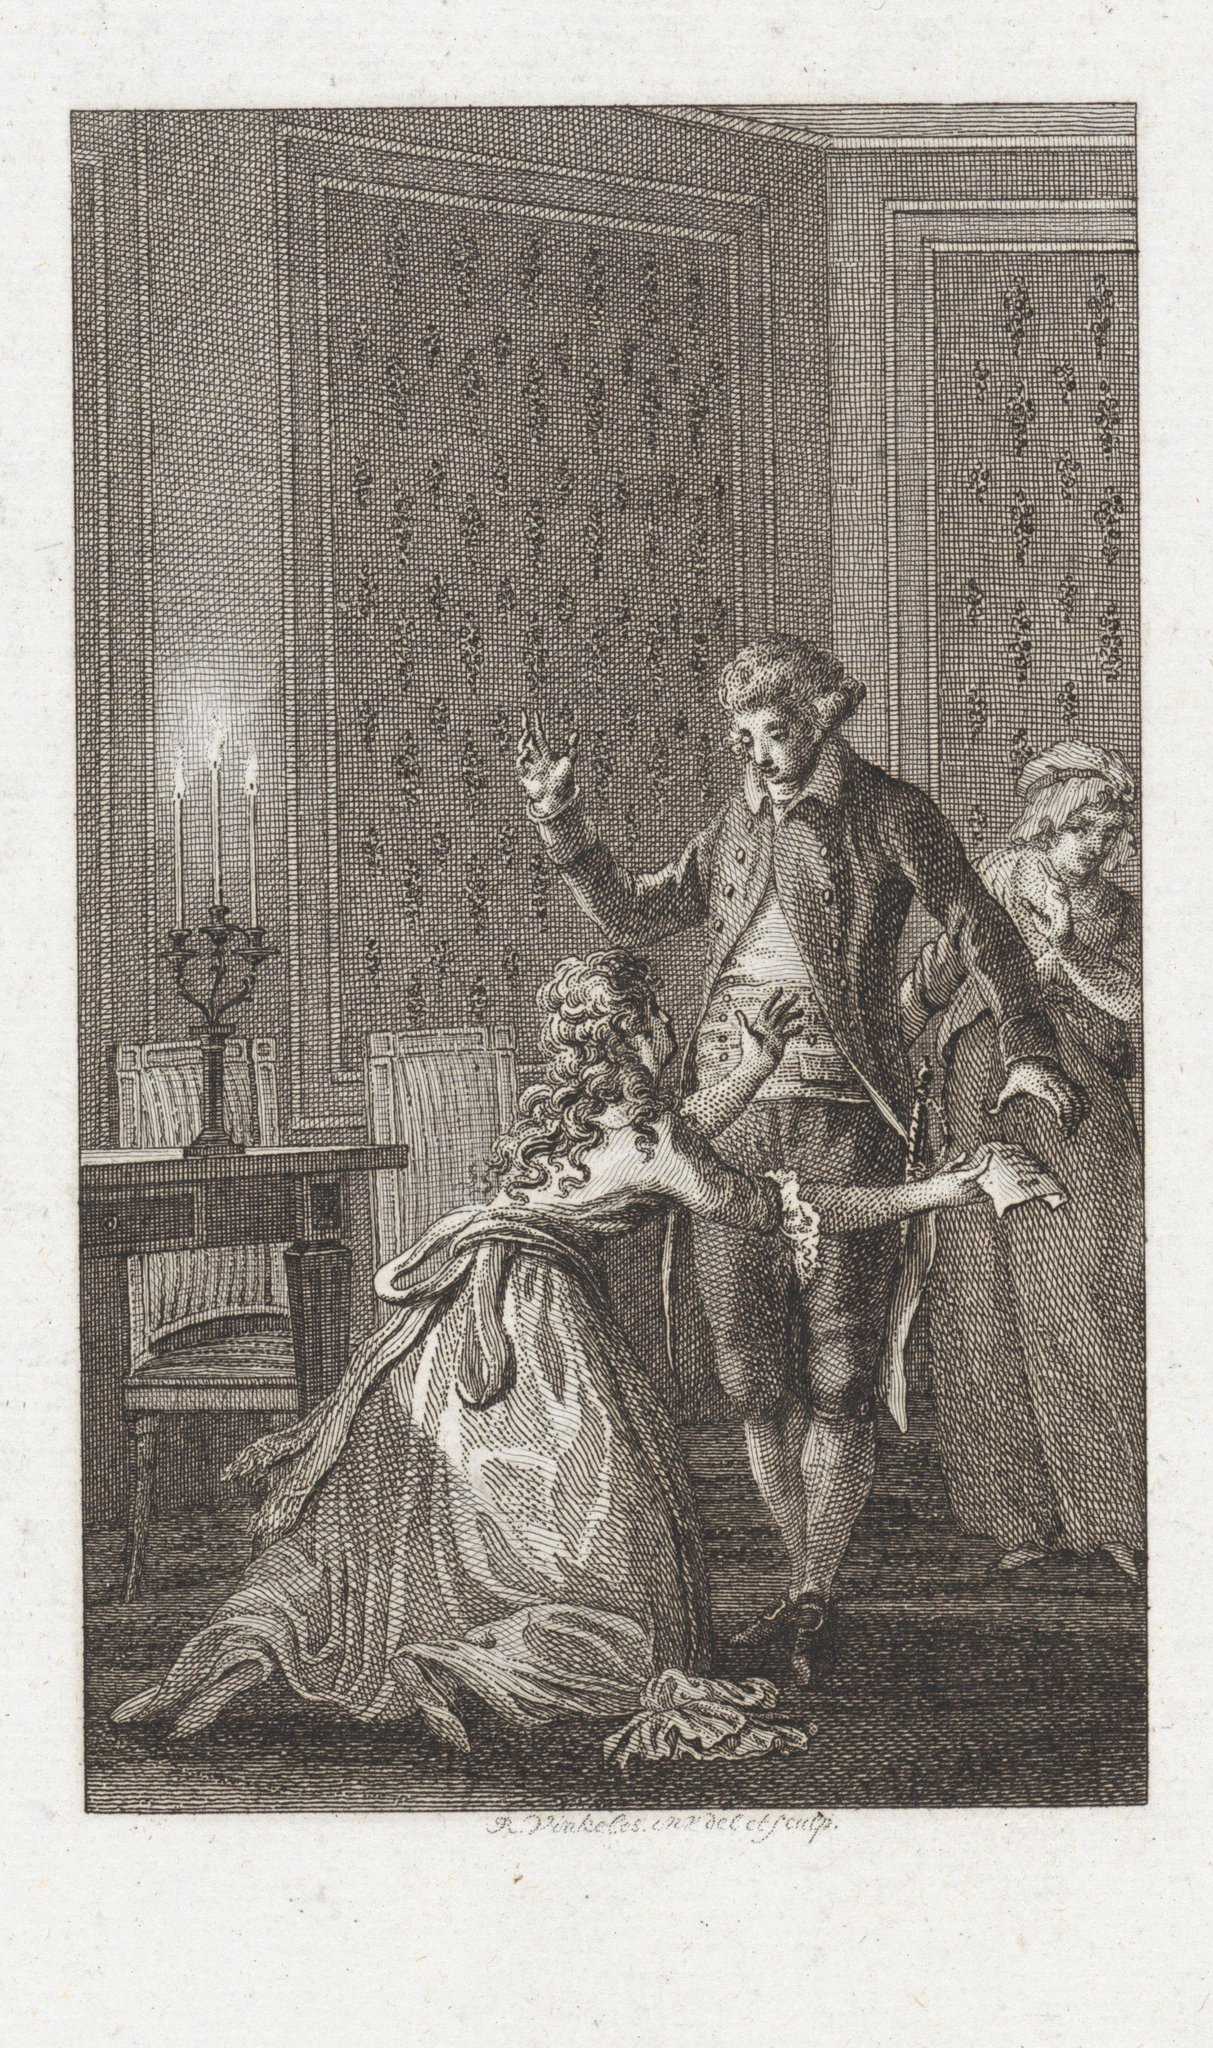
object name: print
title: Vrouw met een brief knielt voor een man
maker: reinier vinkeles (i)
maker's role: draughtsman, print maker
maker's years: 1741-1816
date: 1802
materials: paper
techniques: engraving, etching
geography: amsterdam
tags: candle, kneeling figure, letter, envelope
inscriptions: collector's mark: Lugt 240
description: Illustratie uit: Richardson, Samuel. Geschiedenis van Clarissa Harlowe. Deel 5. Amsterdam: Johannes Allart, 1797-1805.